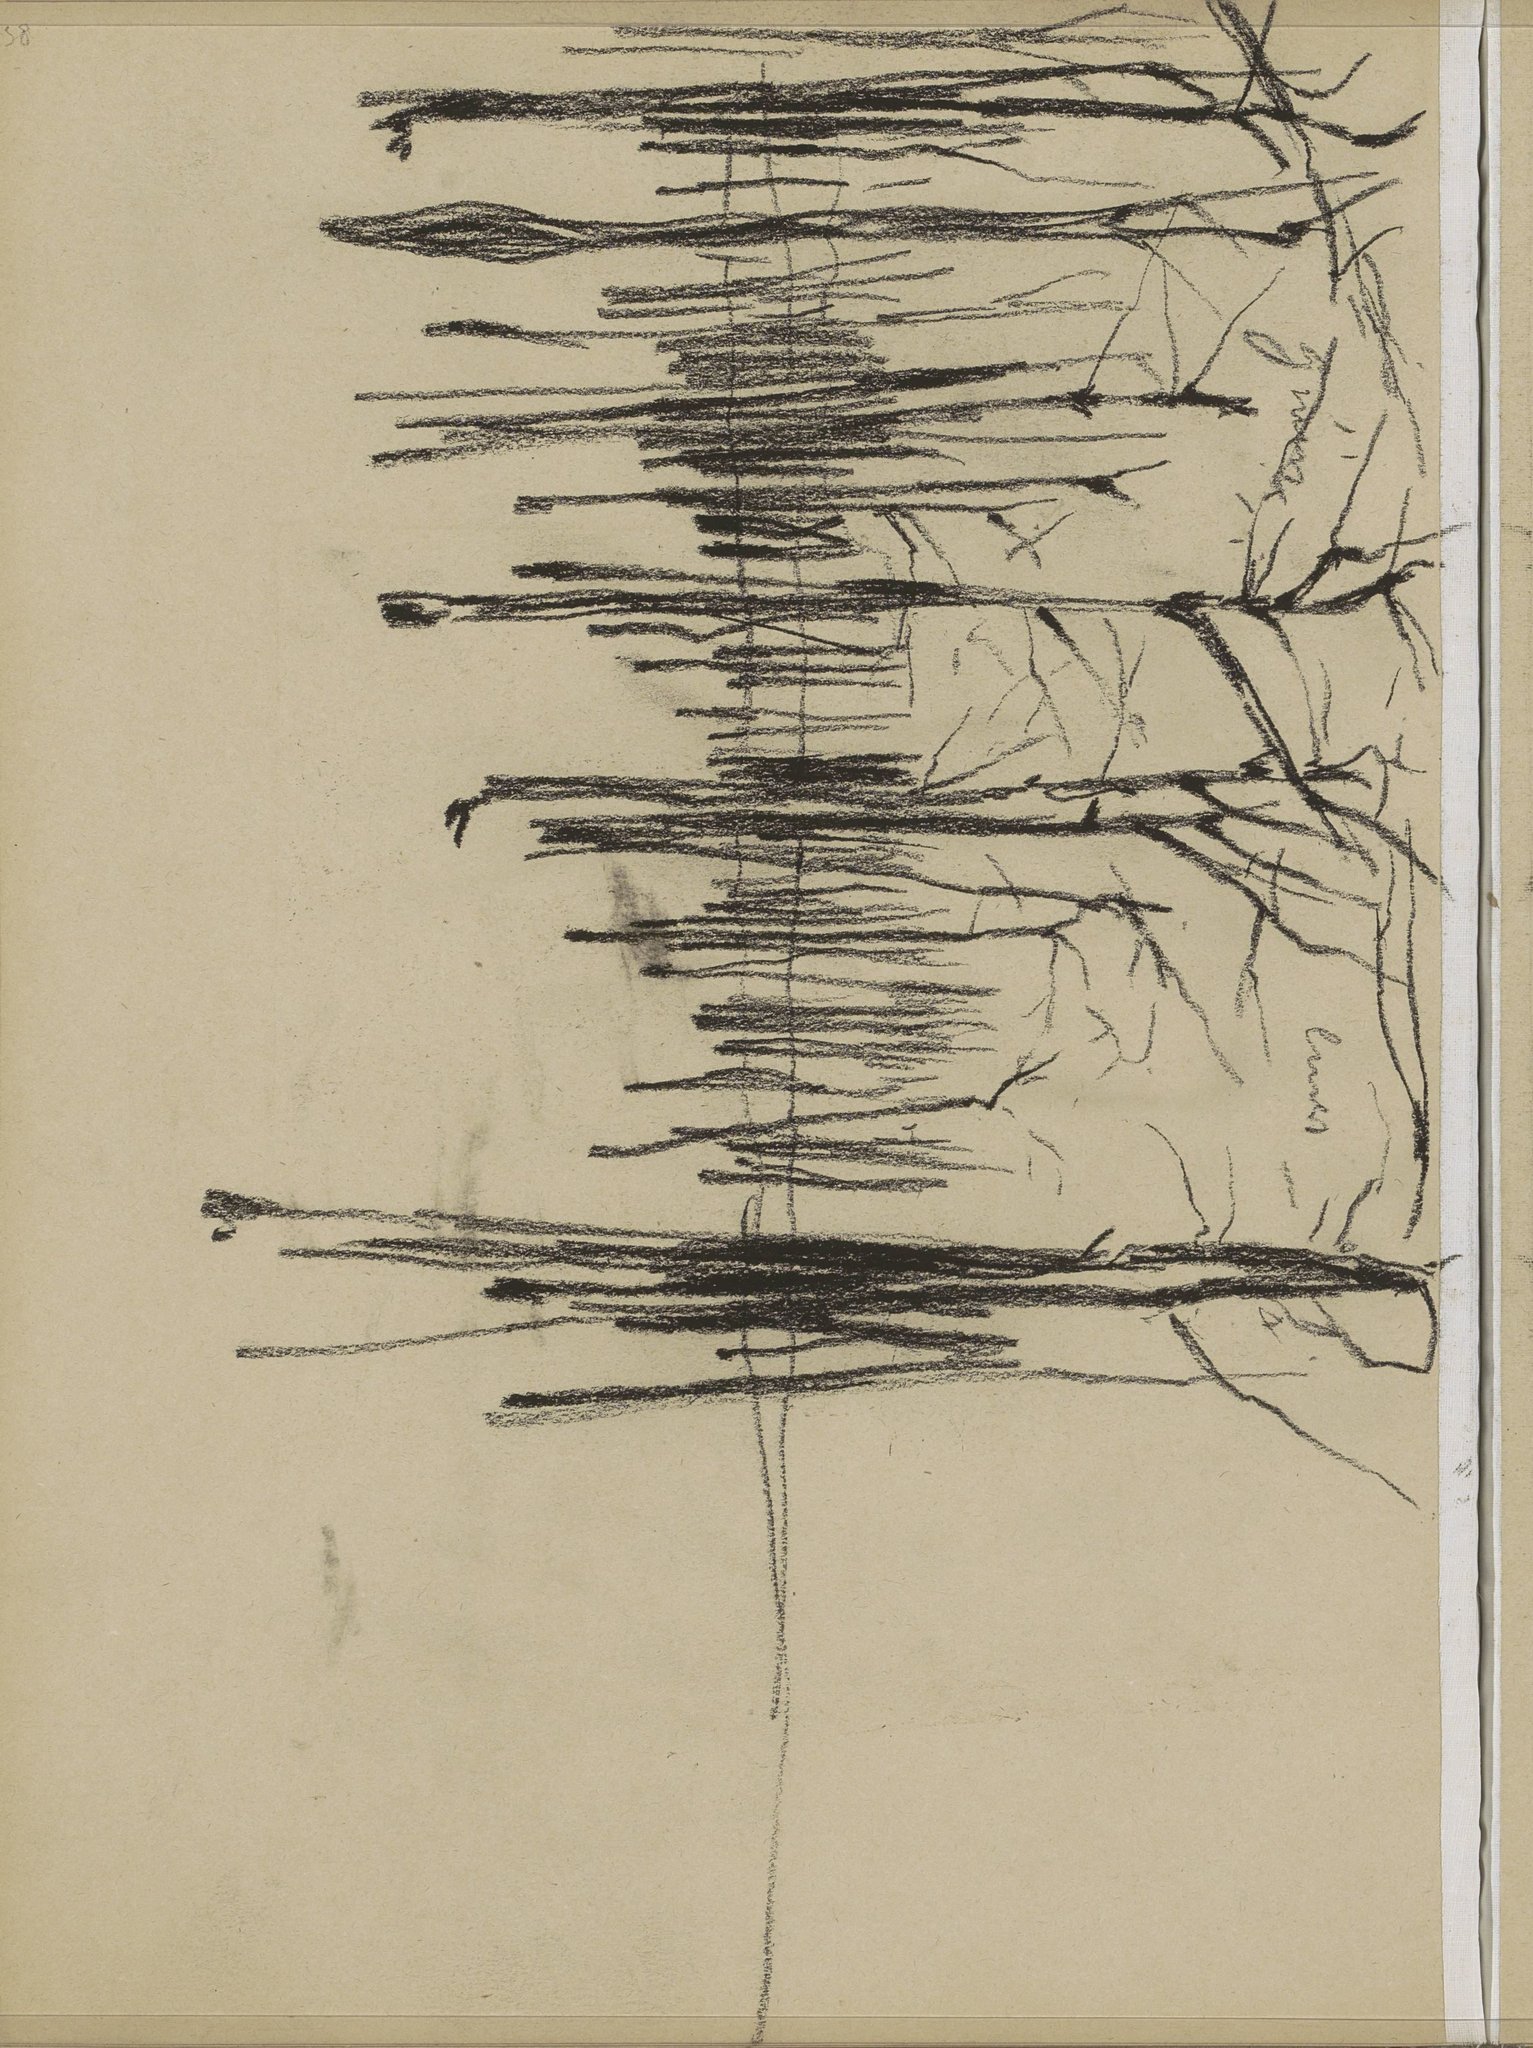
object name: sketchbook leaf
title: Bosgezicht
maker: willem witsen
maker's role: draughtsman, painter, print maker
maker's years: 1860-1923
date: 1874-1923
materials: chalk, paper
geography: ewijkshoeve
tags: hand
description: Pagina 38 uit een schetsboek met 72 bladen.